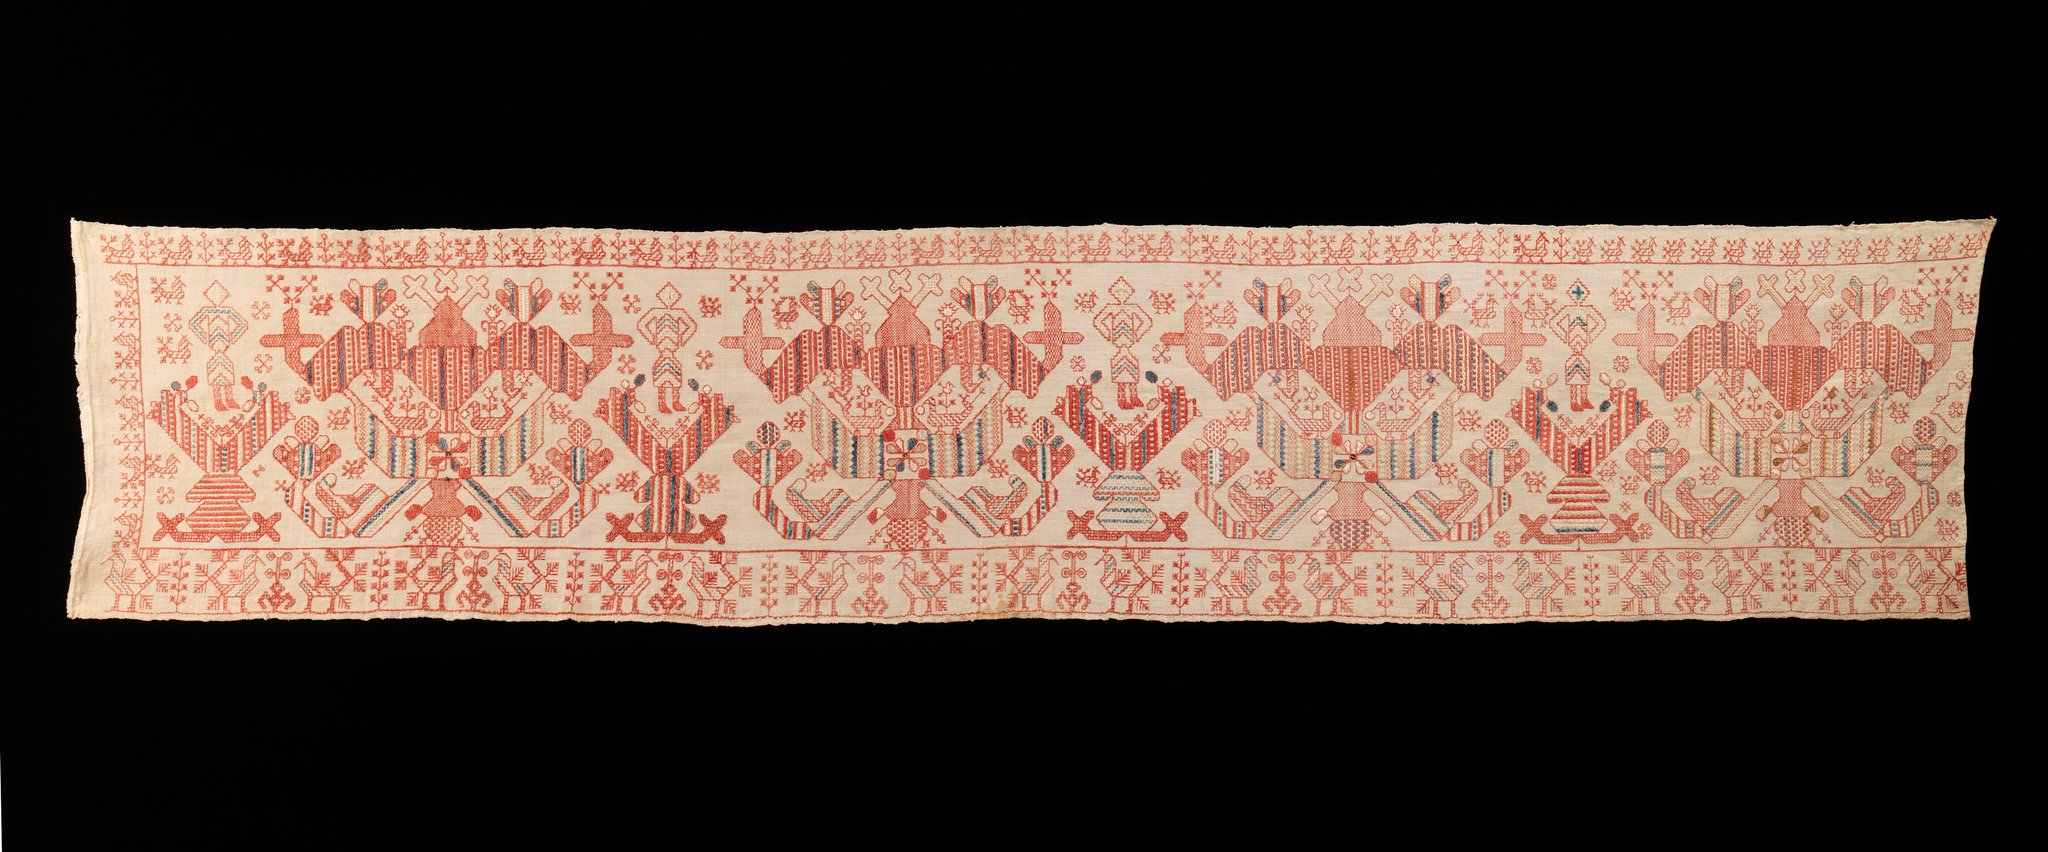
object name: border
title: Bed curtain border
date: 1801-1850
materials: cotton, linen, metal, silk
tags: eagles